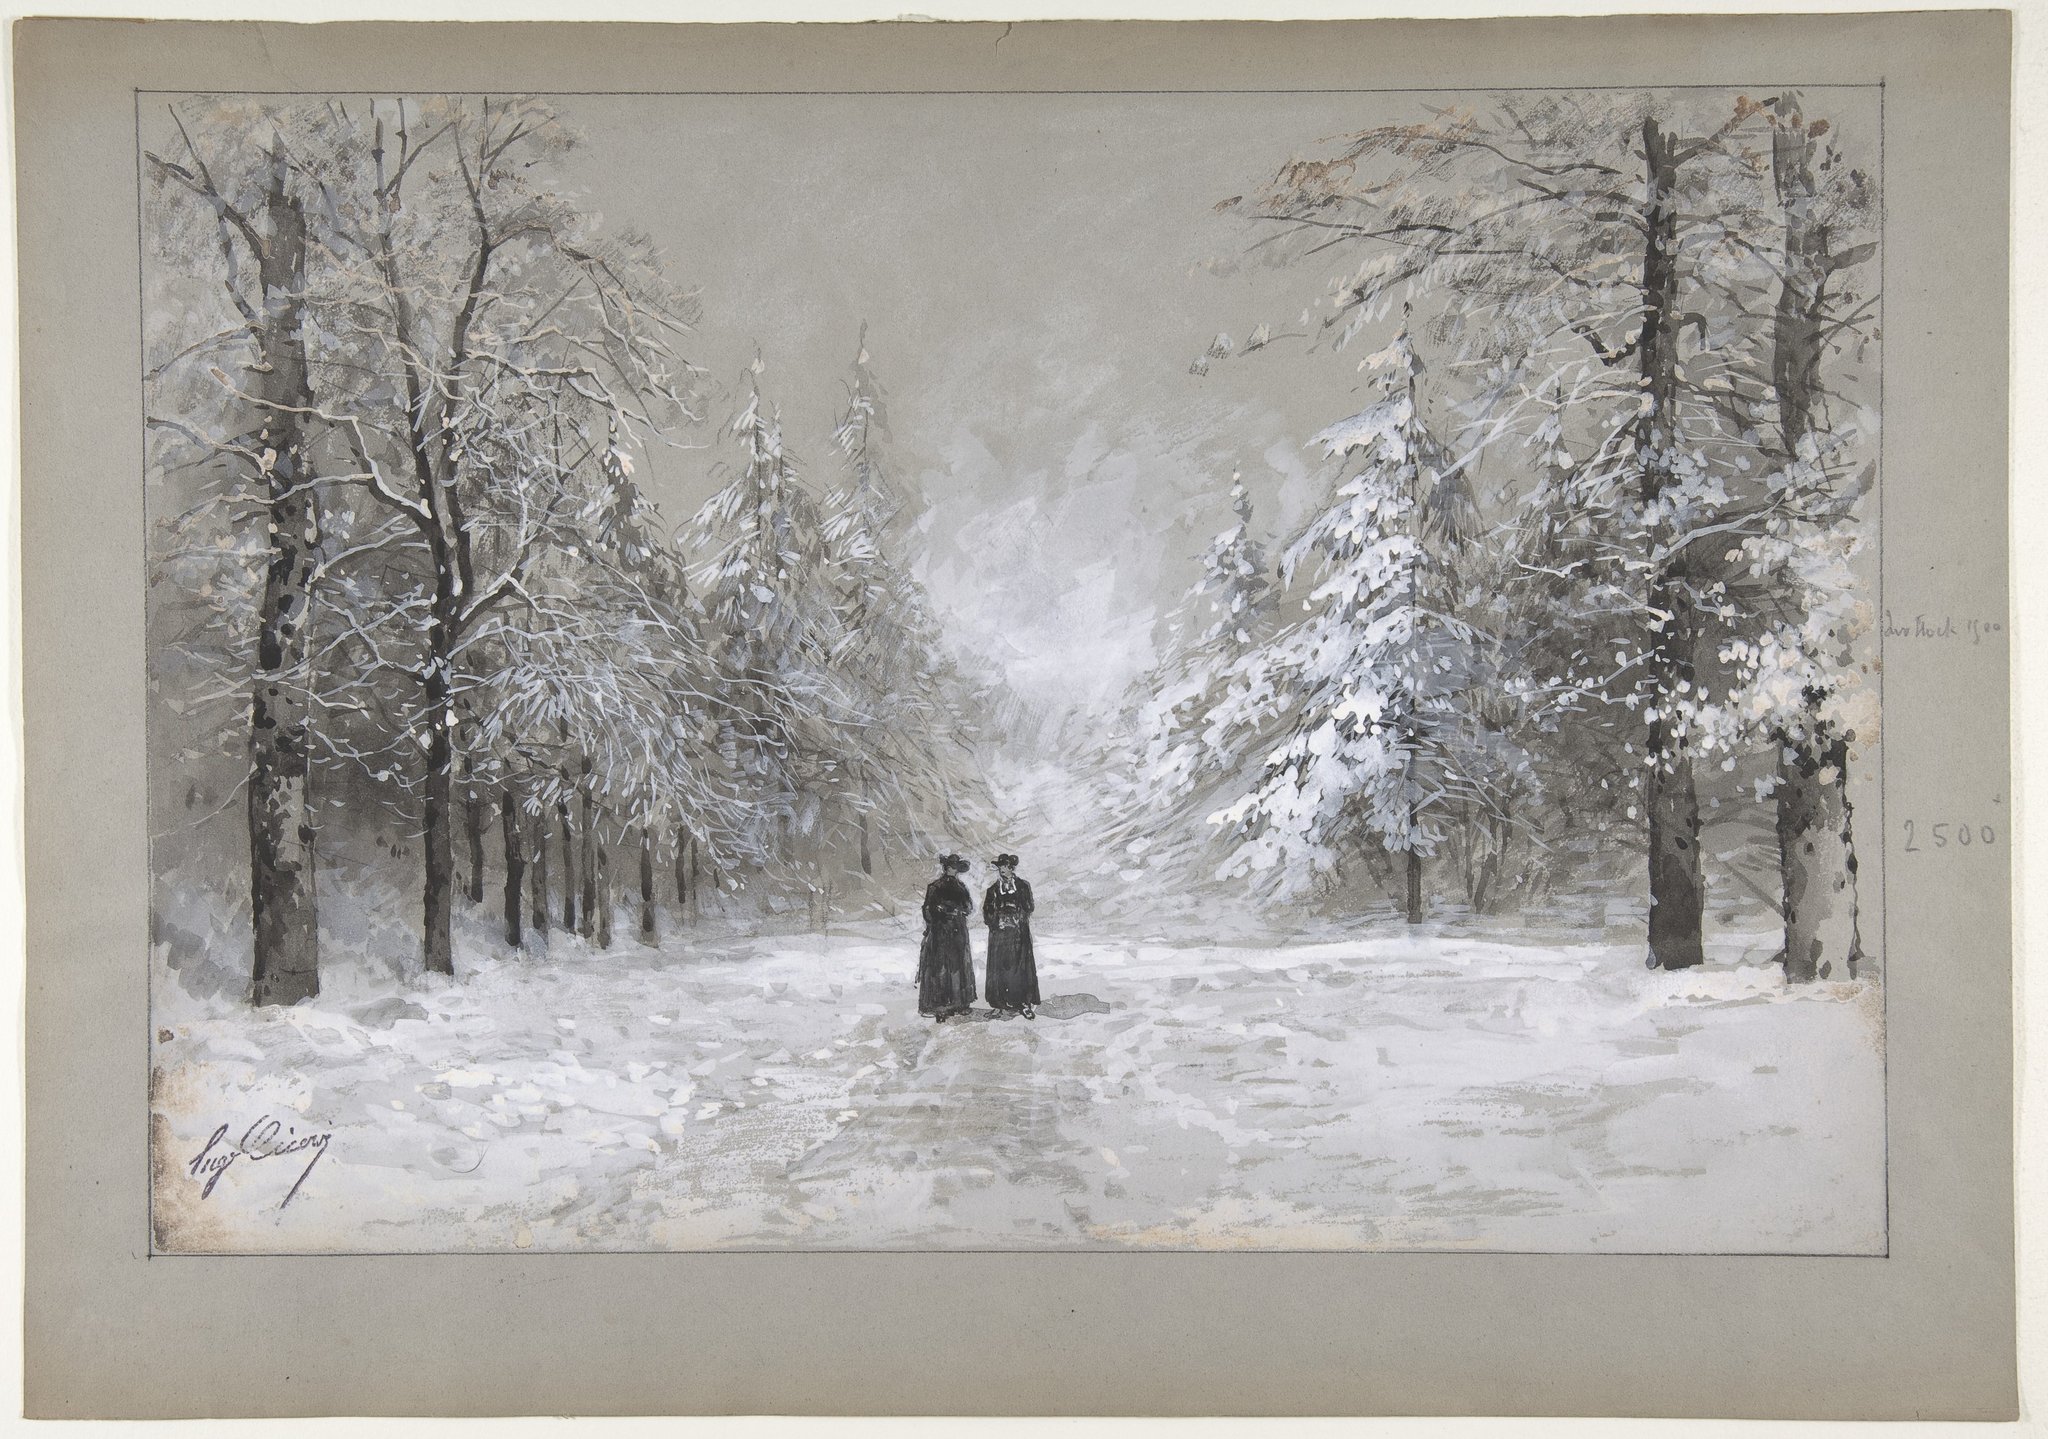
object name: drawing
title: Winter Scene with Two Men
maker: eugène cicéri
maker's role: artist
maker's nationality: french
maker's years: 1813-1890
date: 1830-1890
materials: graphite, watercolor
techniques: heightening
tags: men,trees,winter,snow